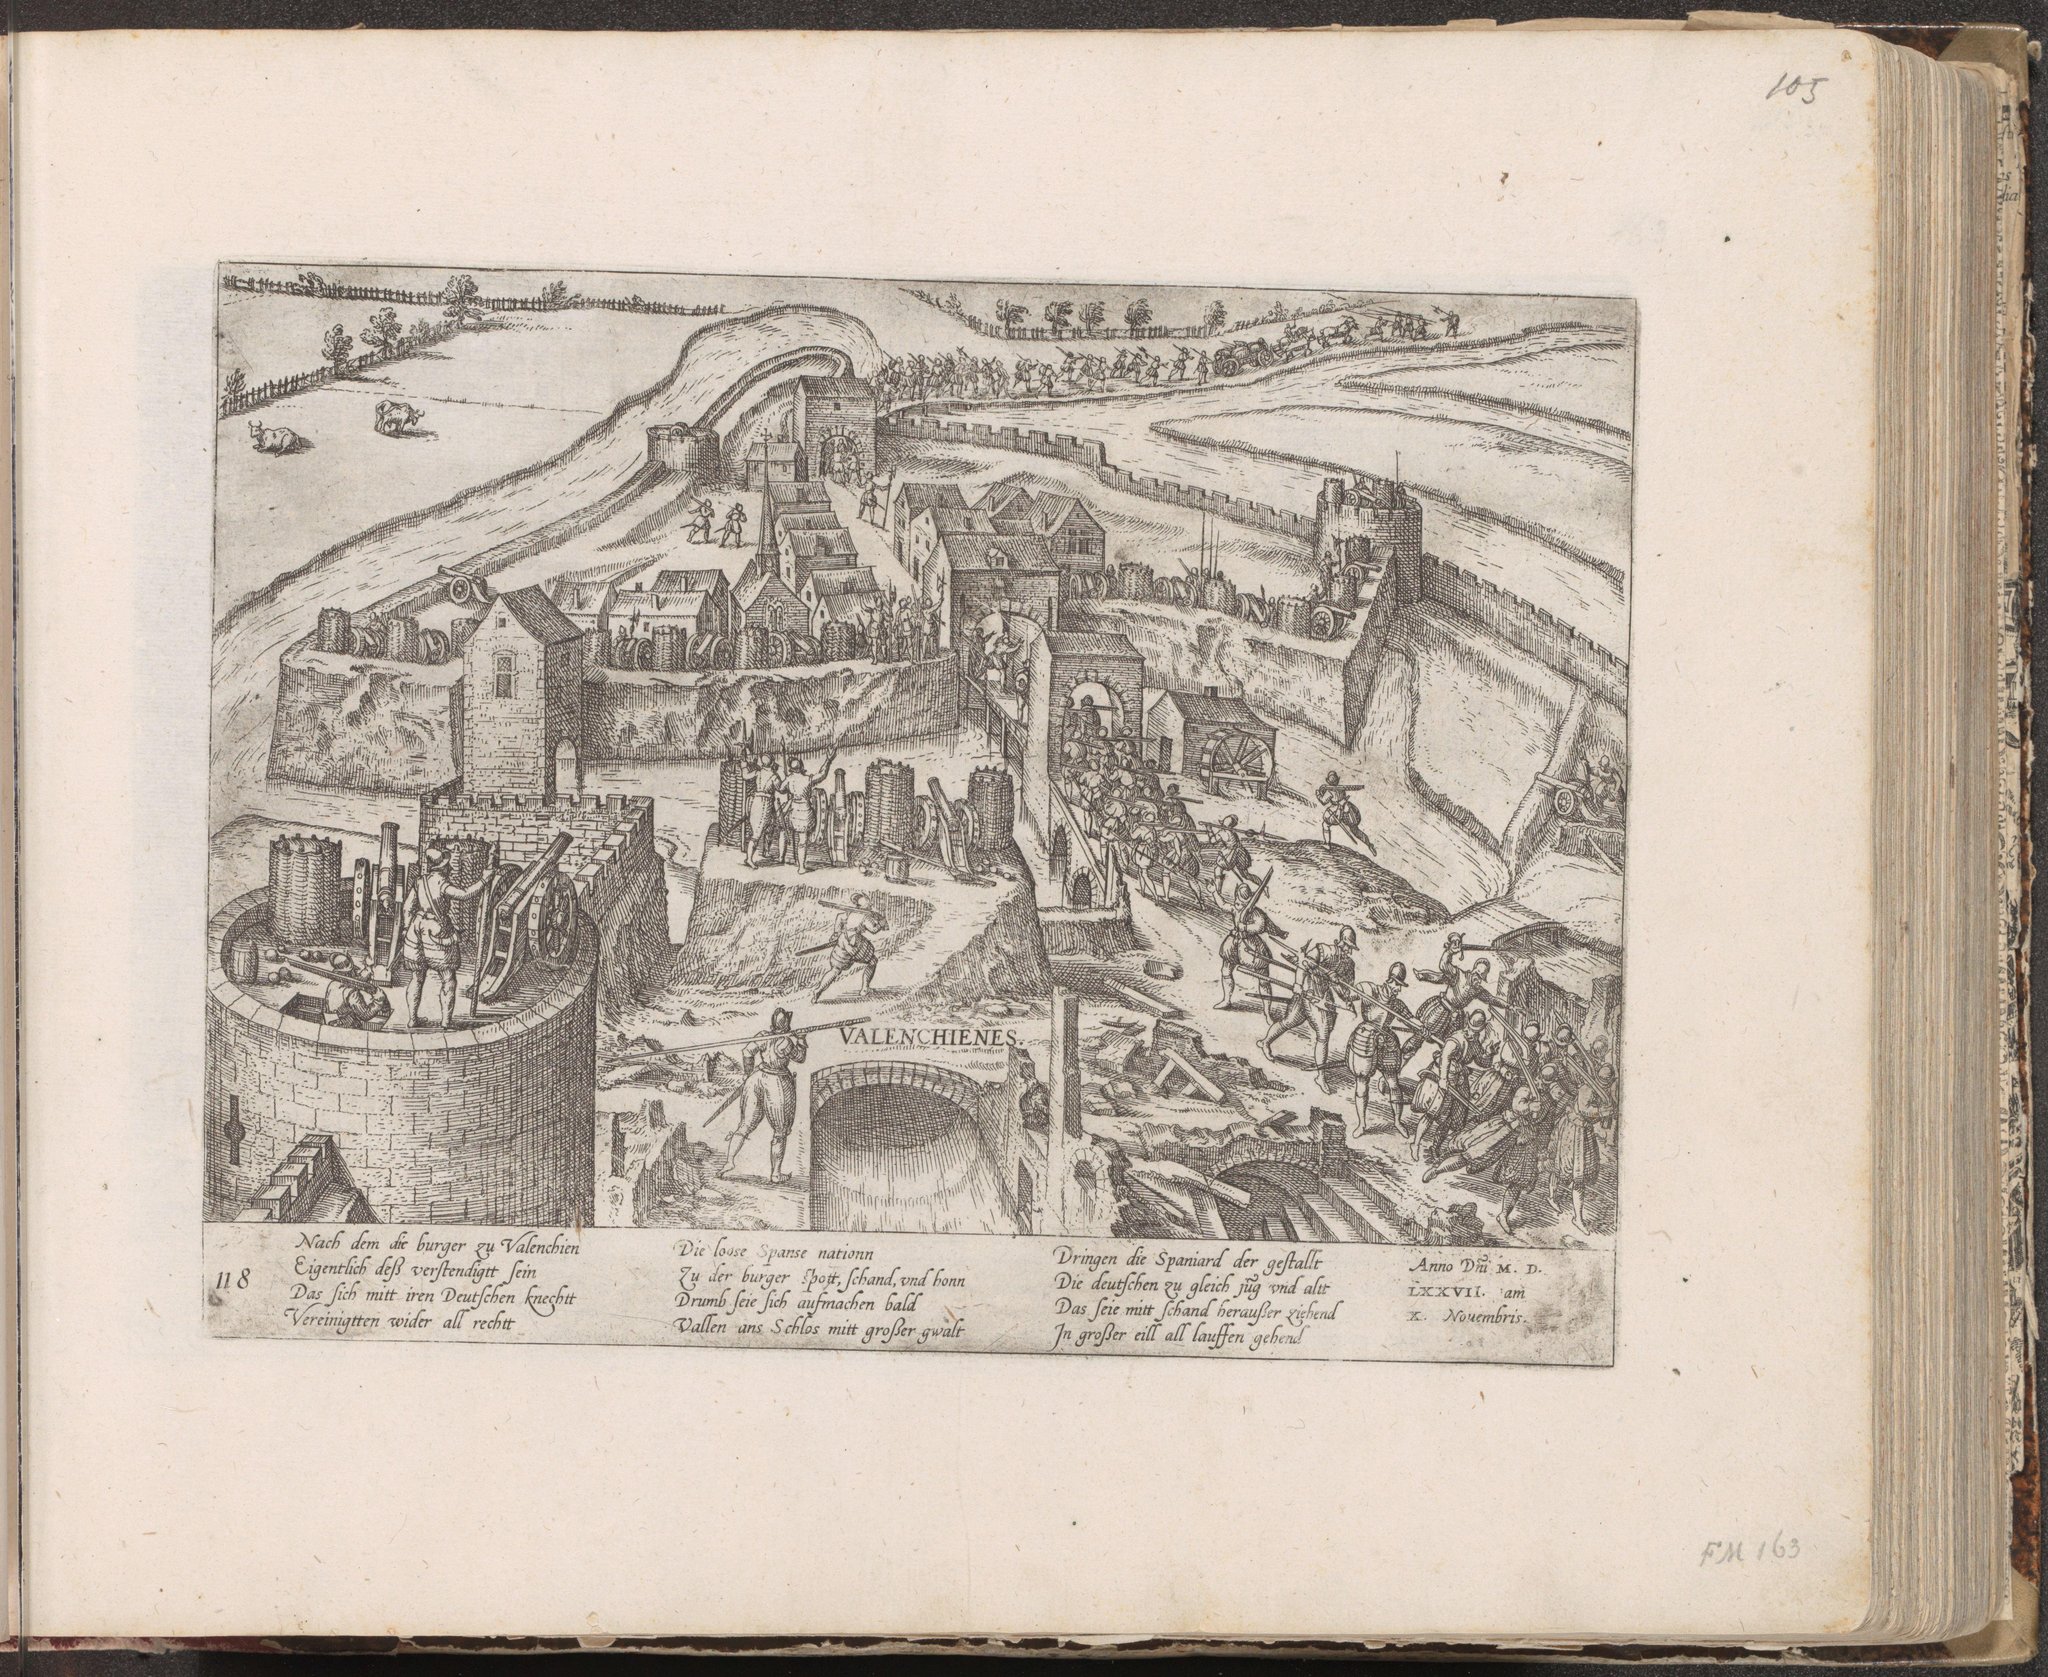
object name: print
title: Serie 7: Nederlandse Gebeurtenissen, 1576-1577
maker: frans hogenberg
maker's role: print maker, publisher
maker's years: 1538-1590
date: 1577-1579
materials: paper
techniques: etching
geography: cologne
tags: capture of city (after the siege)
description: Bevrijding van Valenciennes, 10 november 1576. Verovering van Valenciennes door het Staatse leger en aftocht van de Spanjaarden uit het belegerde slot van Valenciennes. Met onderschrift van 12 regels in het Duits. Linksonder genummerd: 118. De prent maakt deel uit van een album.